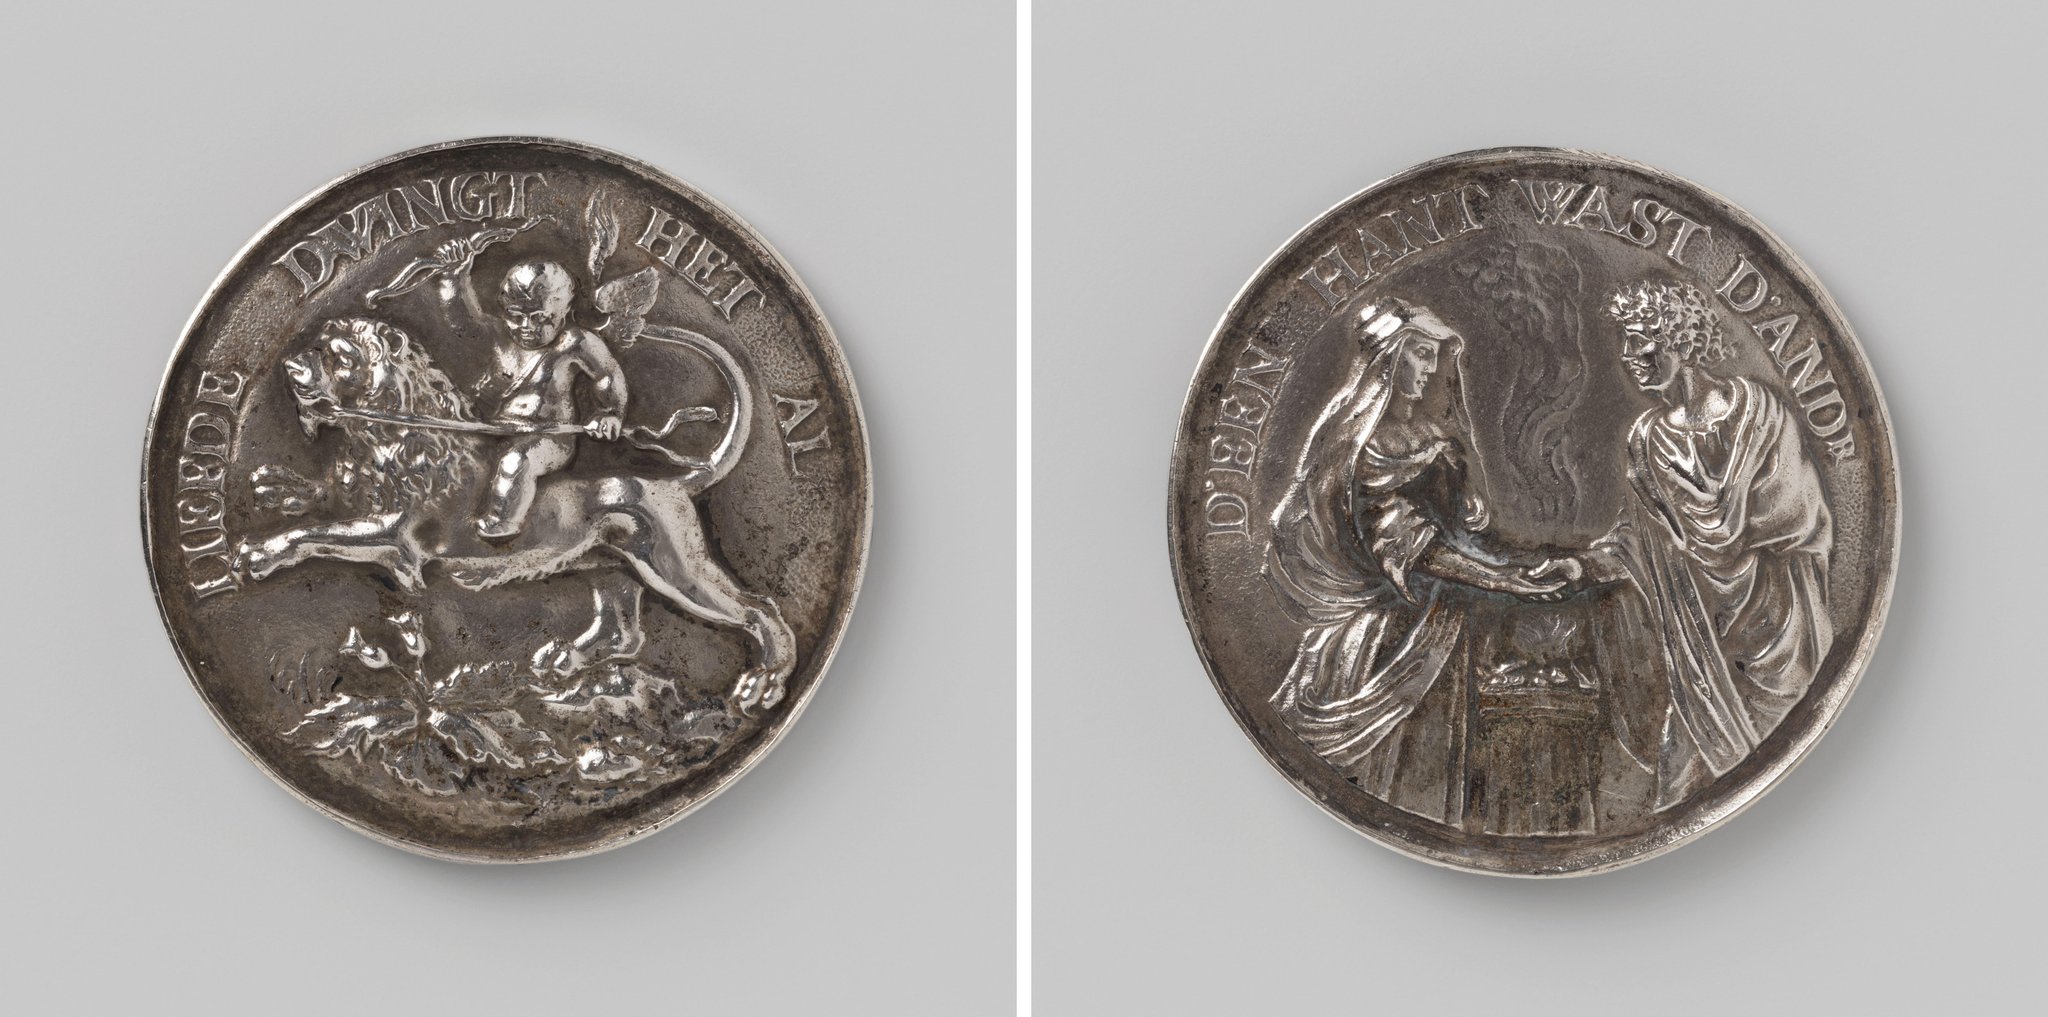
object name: marriage medal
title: Het huwelijk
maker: pieter van abeele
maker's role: draughtsman, jeweler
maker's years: 1608-1684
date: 1658-1659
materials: silver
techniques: casting, engraving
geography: amsterdam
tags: marriage, married couple, 'matrimonium'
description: Zilveren penning. Voorzijde: Amor met boog in hand, rijdend op leeuw; op voorgrond distelplant binnen omschrift. Keerzijde: man en vrouw in Romeinse kledij geven elkaar hand boven brandend altaar binnen omschrift